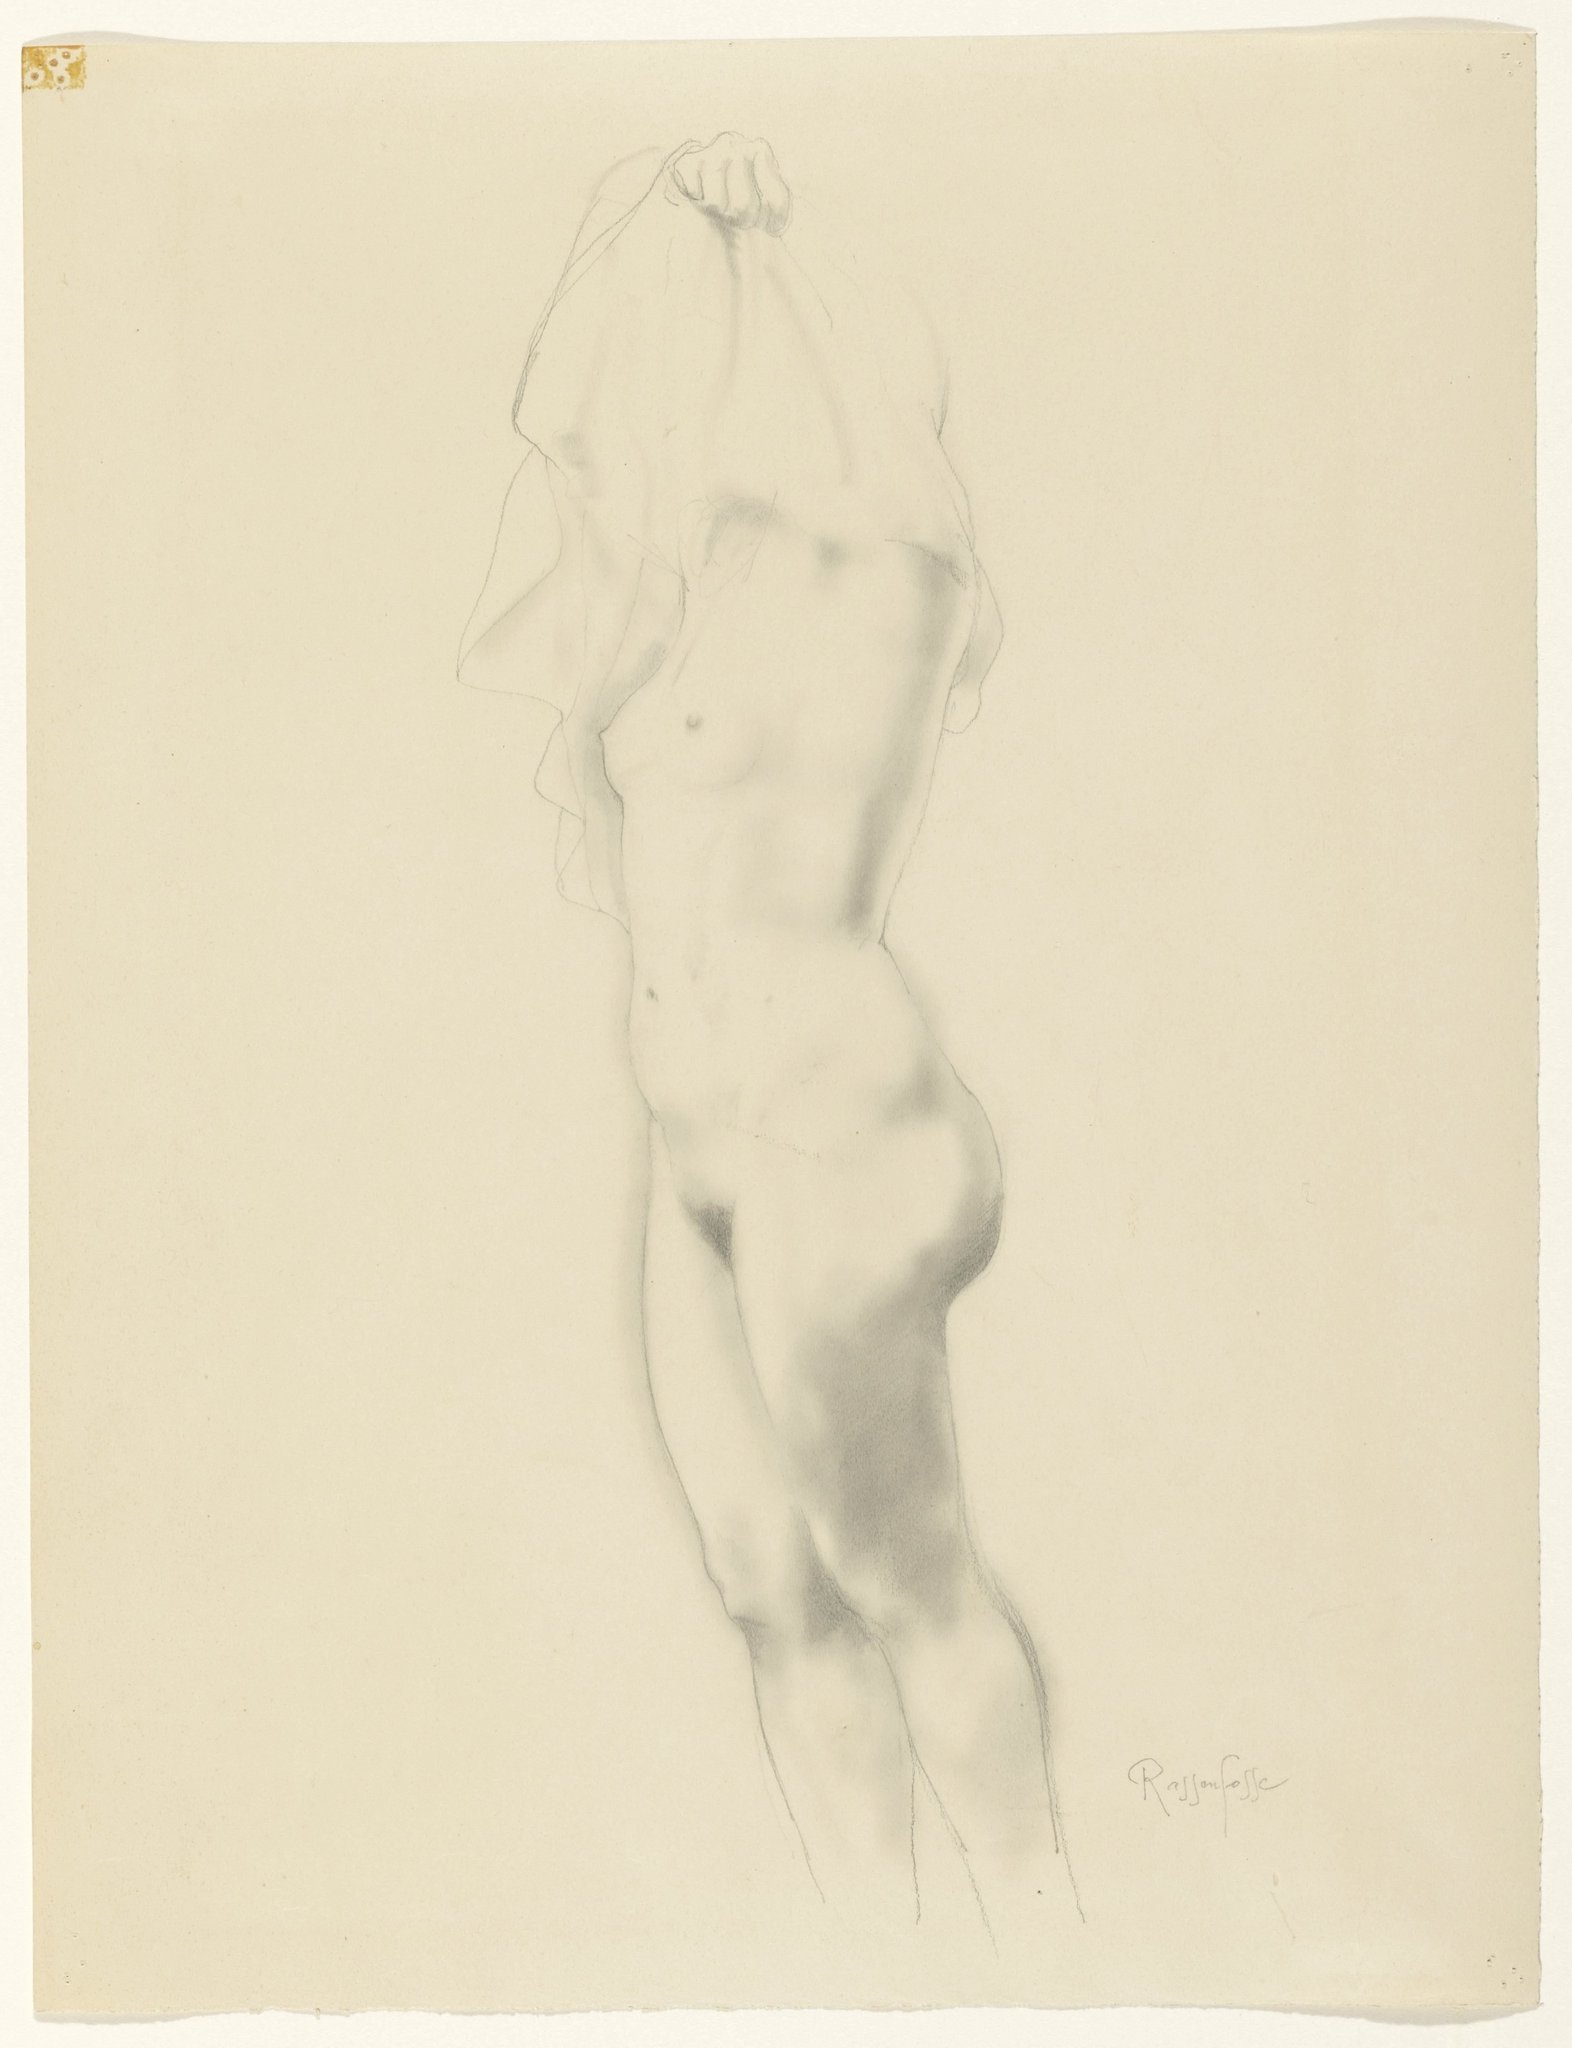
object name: drawing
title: Standing Female Nude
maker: armand rassenfosse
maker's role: draughtsman, painter, print maker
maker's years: 1862-1934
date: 1872-1934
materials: chalk, paper, pencil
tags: undressing oneself, getting undressed, standing figure - aa - female human figure